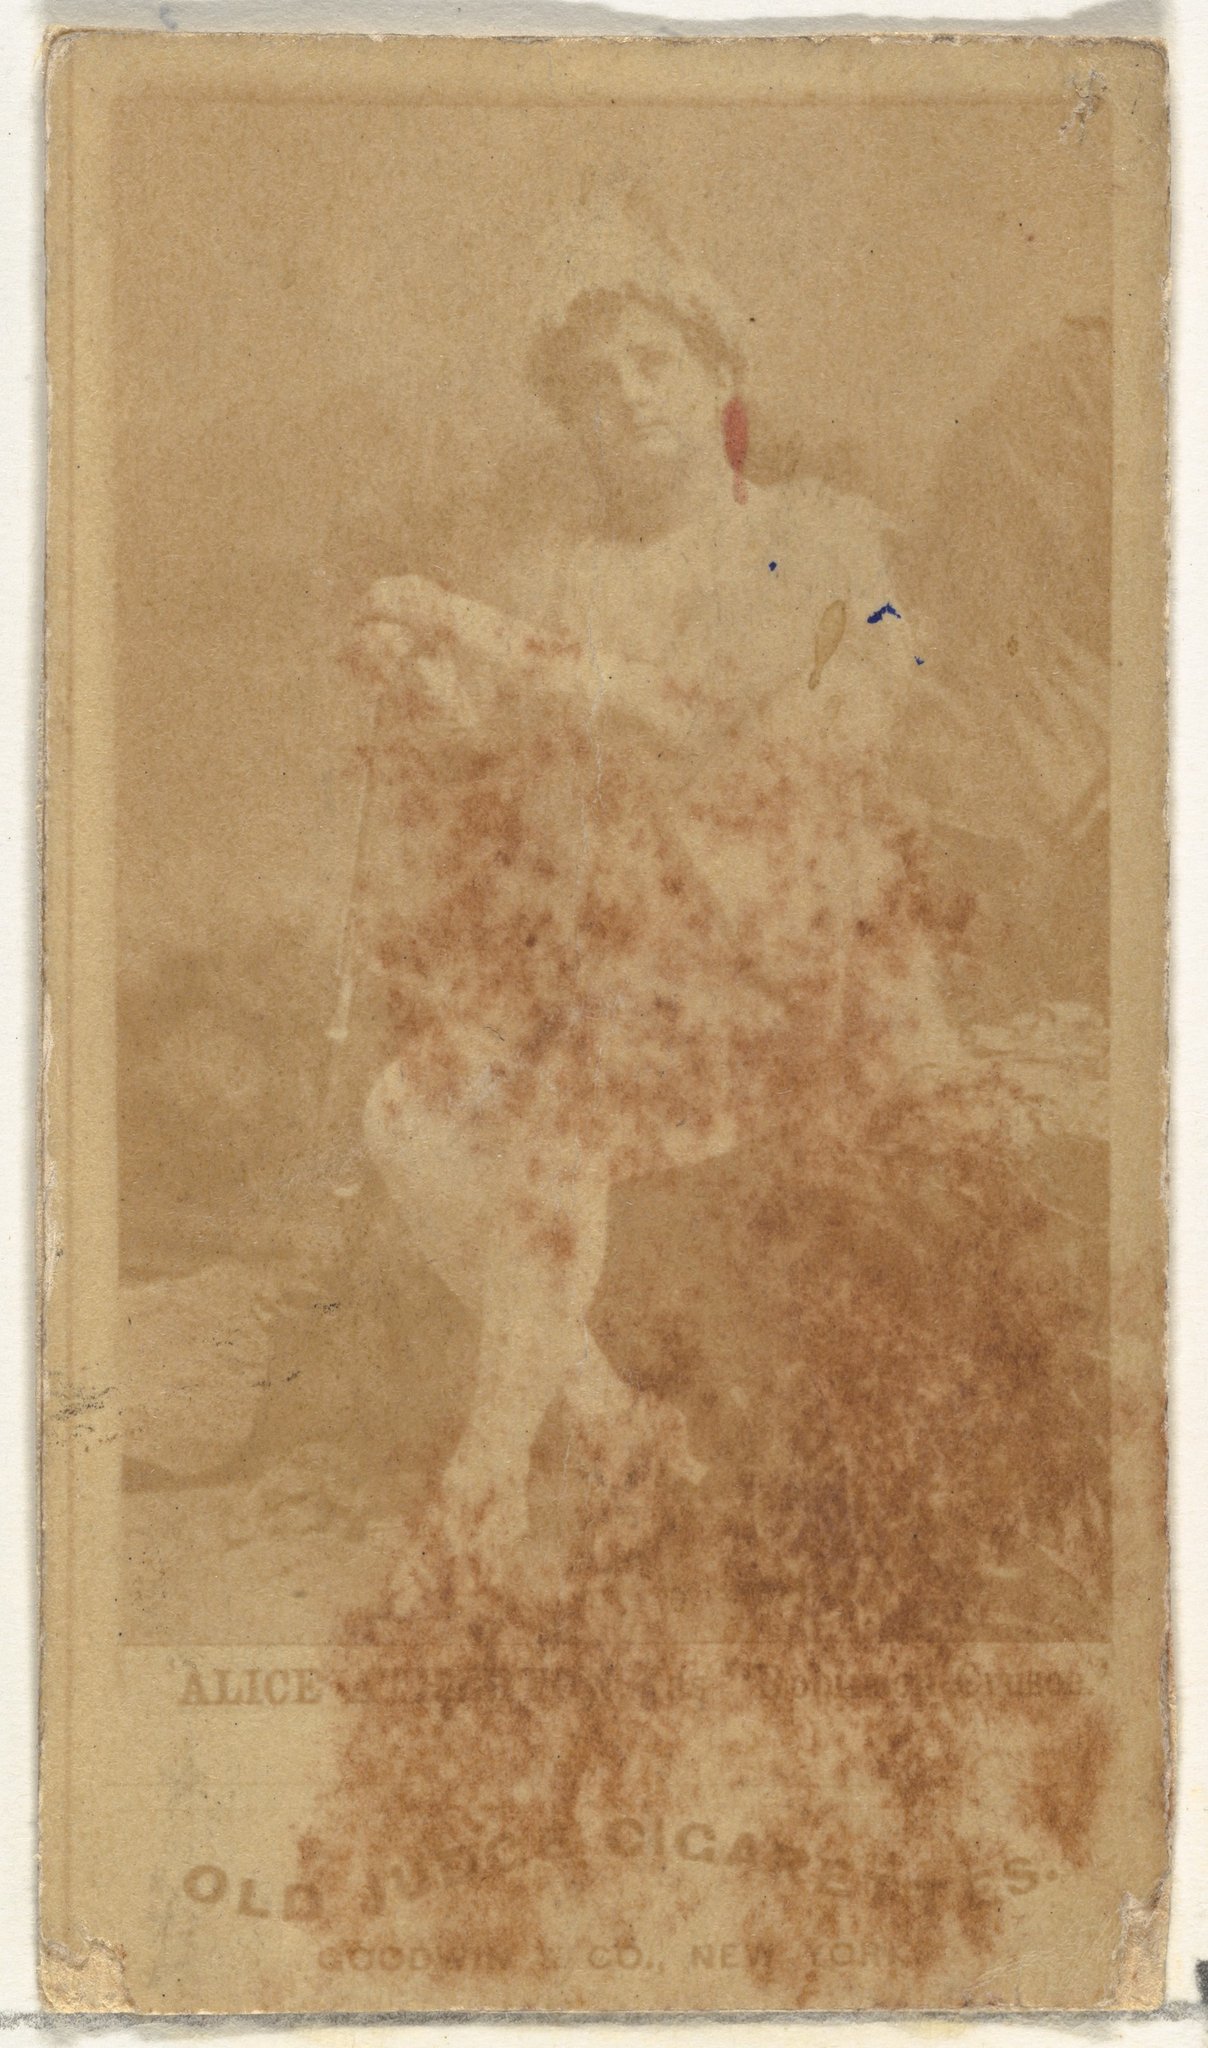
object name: photograph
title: From the Actors and Actresses series (N171) for Old Judge Cigarettes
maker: goodwin & company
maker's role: publisher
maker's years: 1850-1950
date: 1886-1890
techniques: albumen silver print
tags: portraits,women